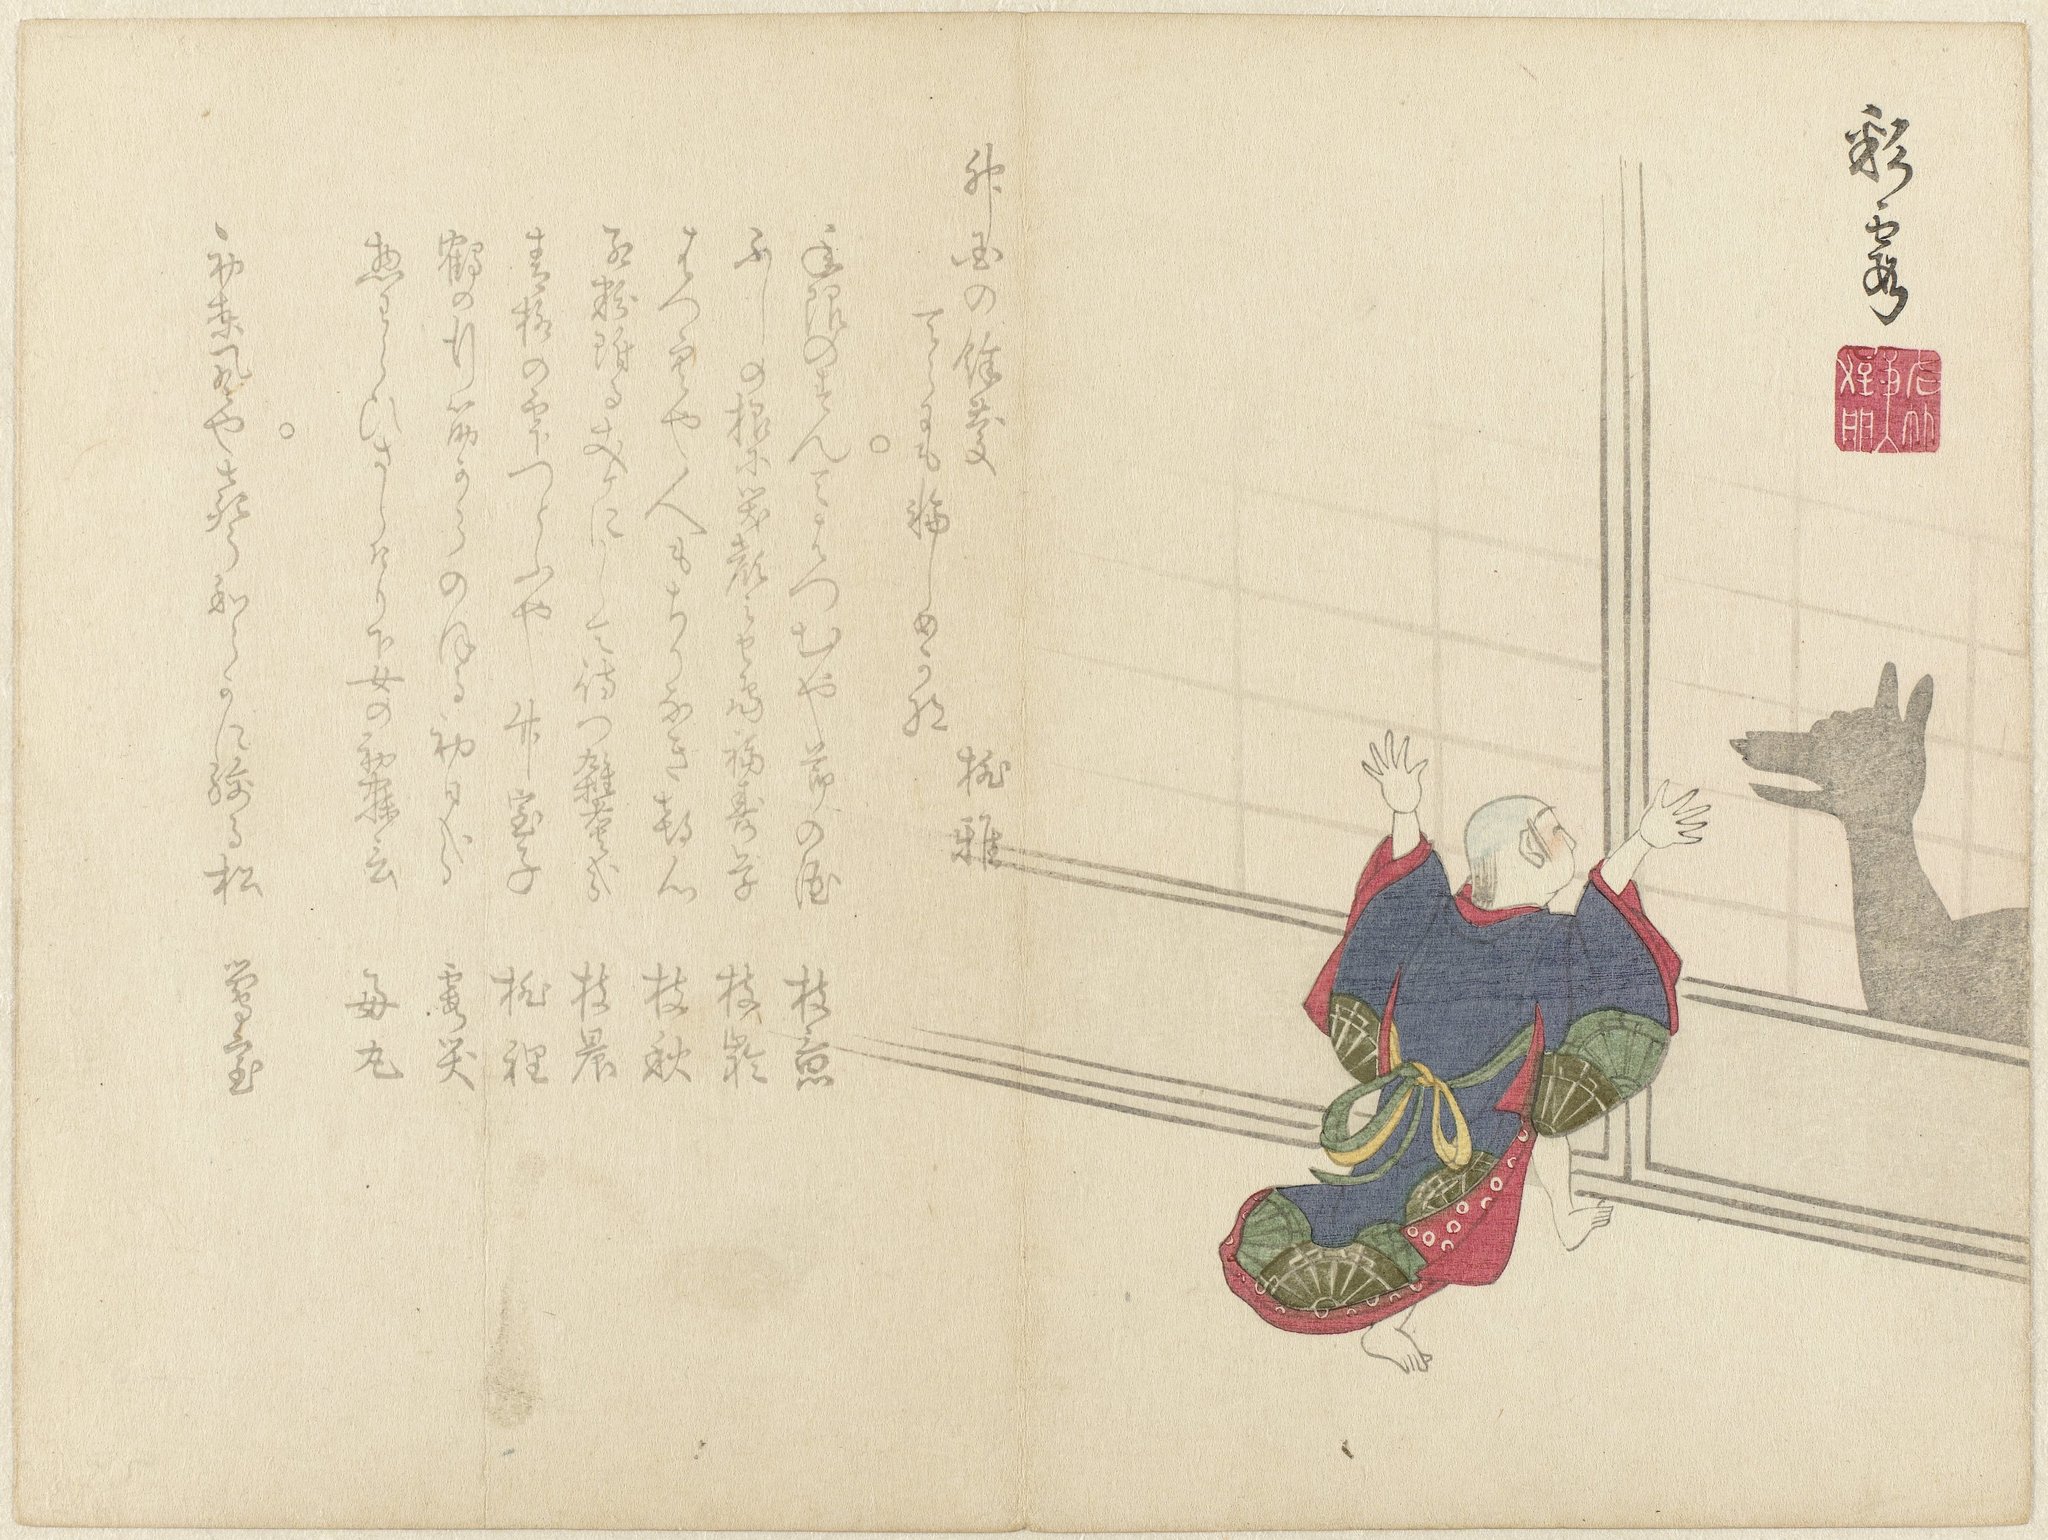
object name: print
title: Jongen met schaduw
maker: saikai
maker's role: print maker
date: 1850-1880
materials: paper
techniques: woodcut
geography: japan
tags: shadow, oriental ideographic script (chinese, korean, japanese)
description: Een surimono is een luxe uitgevoerde prent waarop beeld met één of meerdere gedichten gecombineerd is. Bij het drukken van een surimono werd vaak gebruik gemaakt van dikker papier, blinddruk en metaal pigmenten, zoals koper- en zilverpoeder. De prenten werden vaak in opdracht van dichters gemaakt en als exclusief geschenk aan vrienden en relaties gegeven.